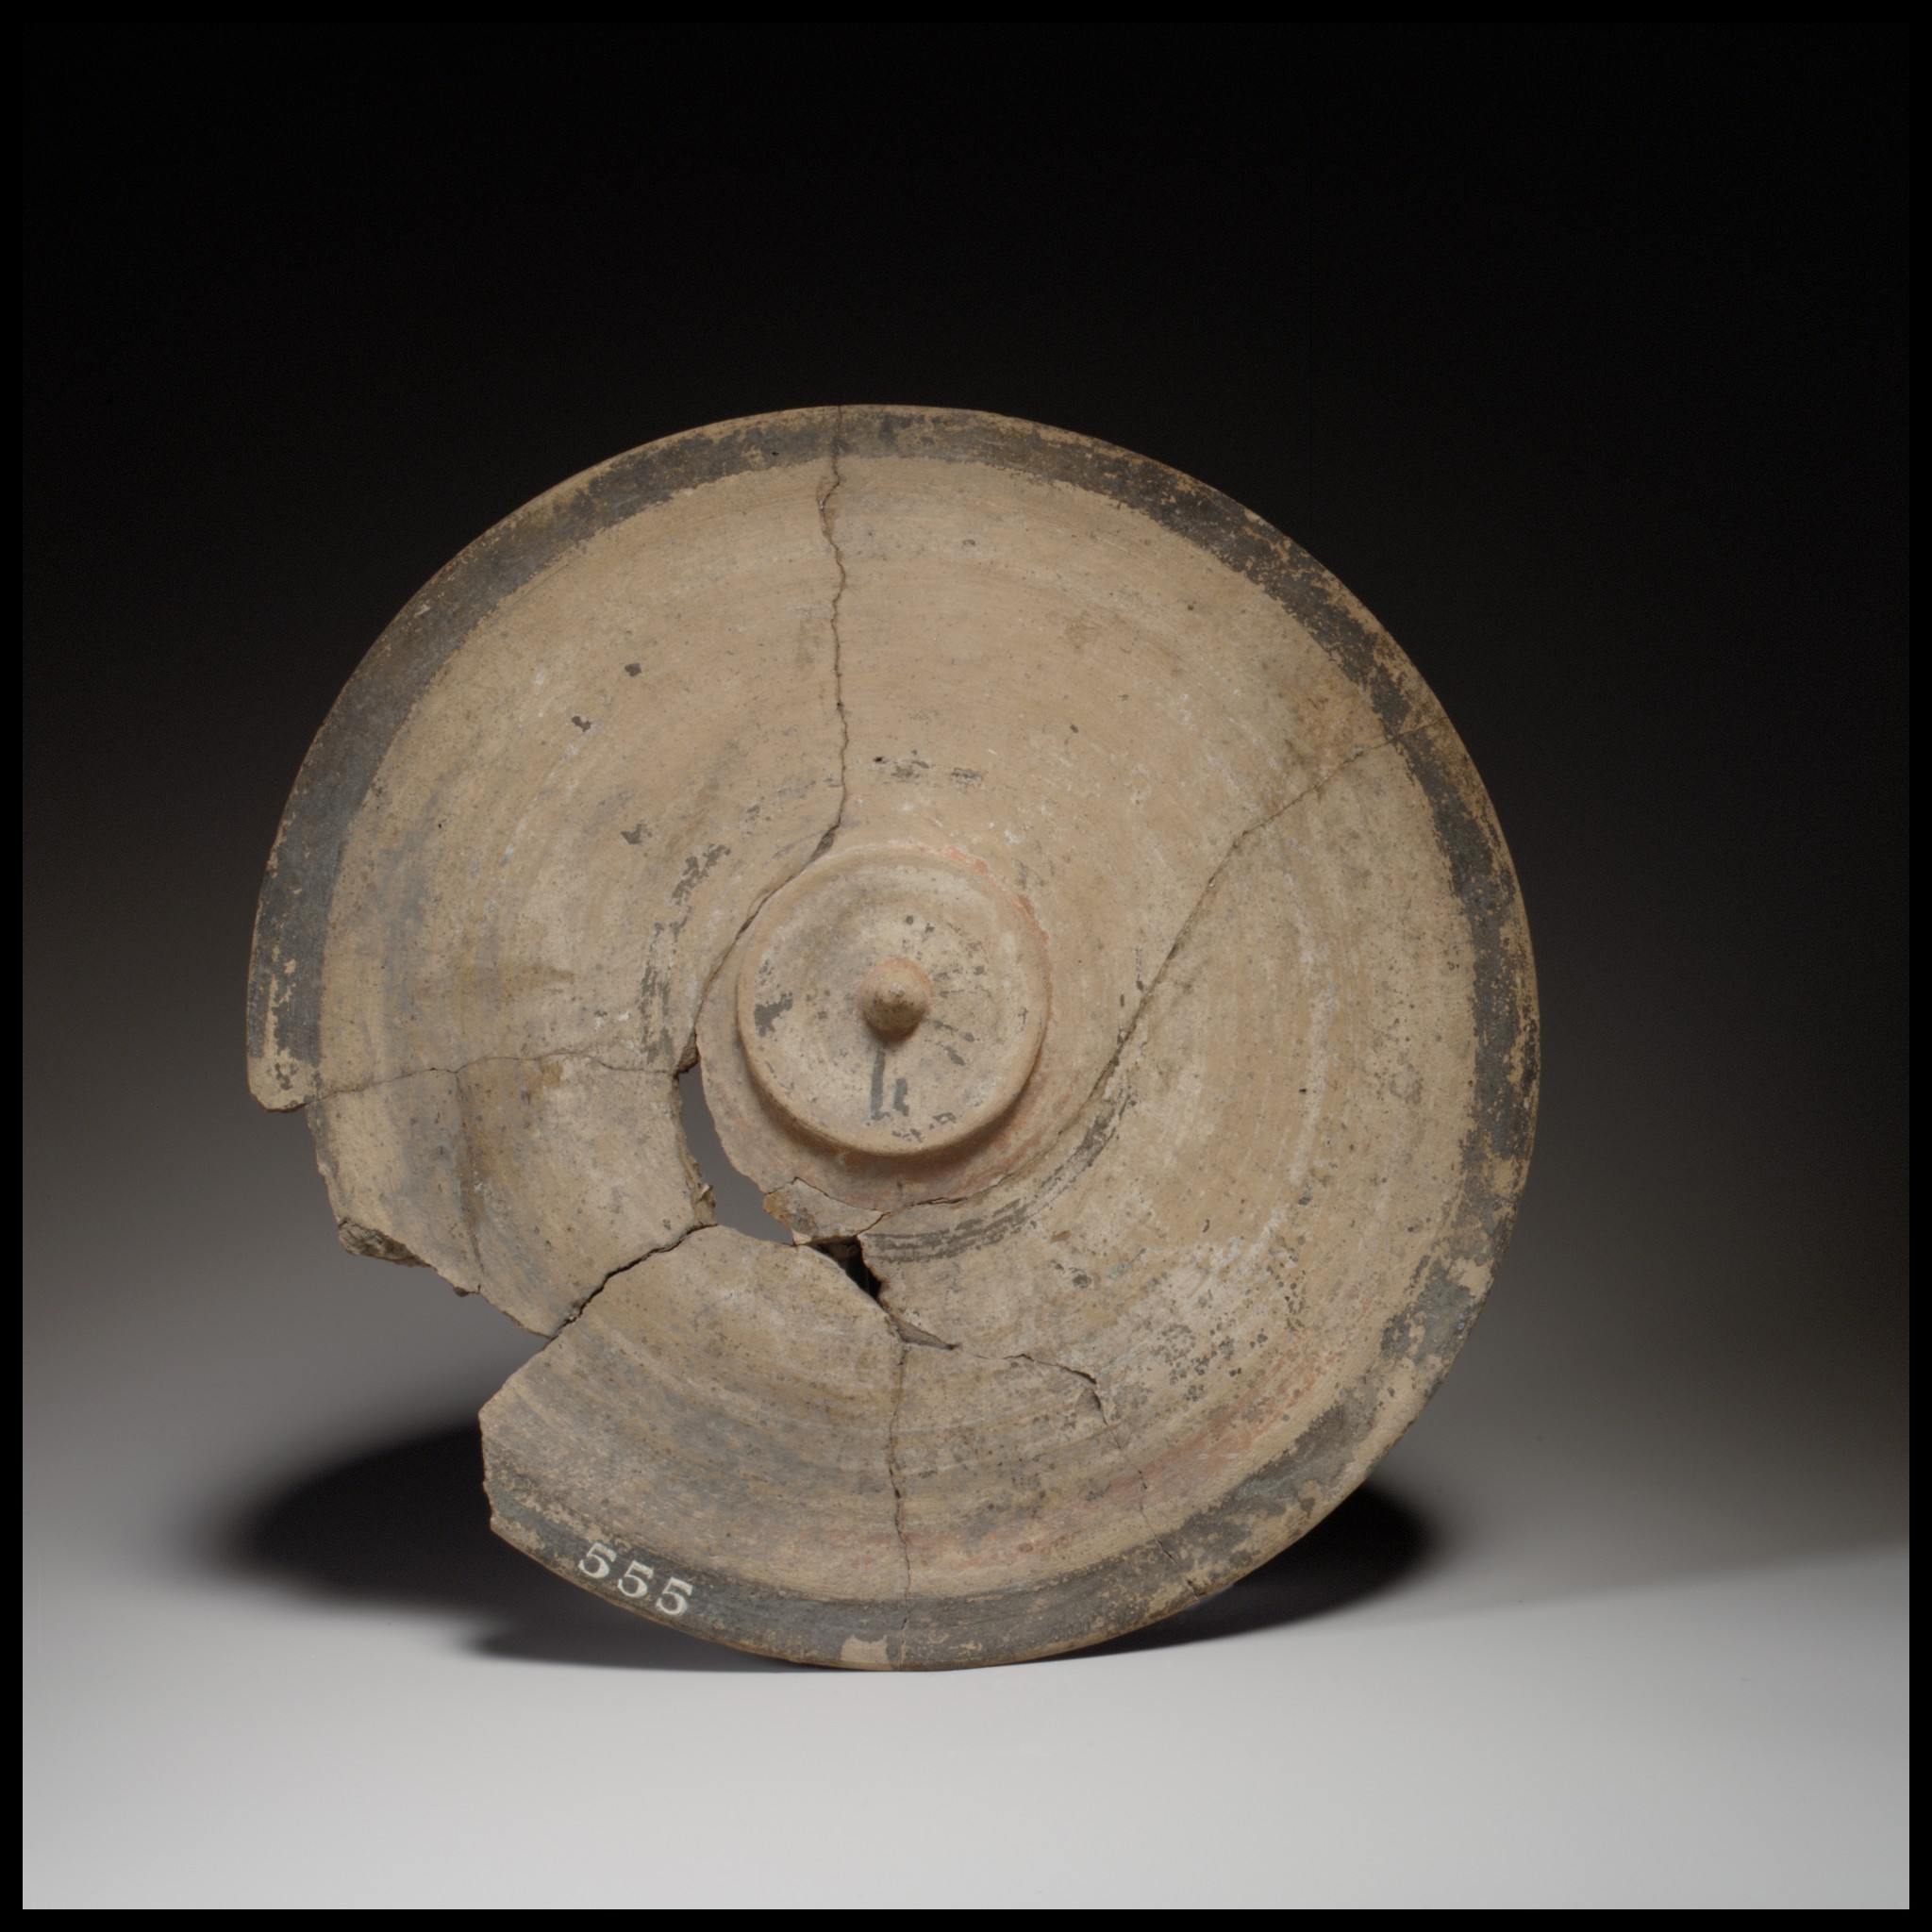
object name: shield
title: Votive shield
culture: cypriot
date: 600-480 BCE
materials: terracotta